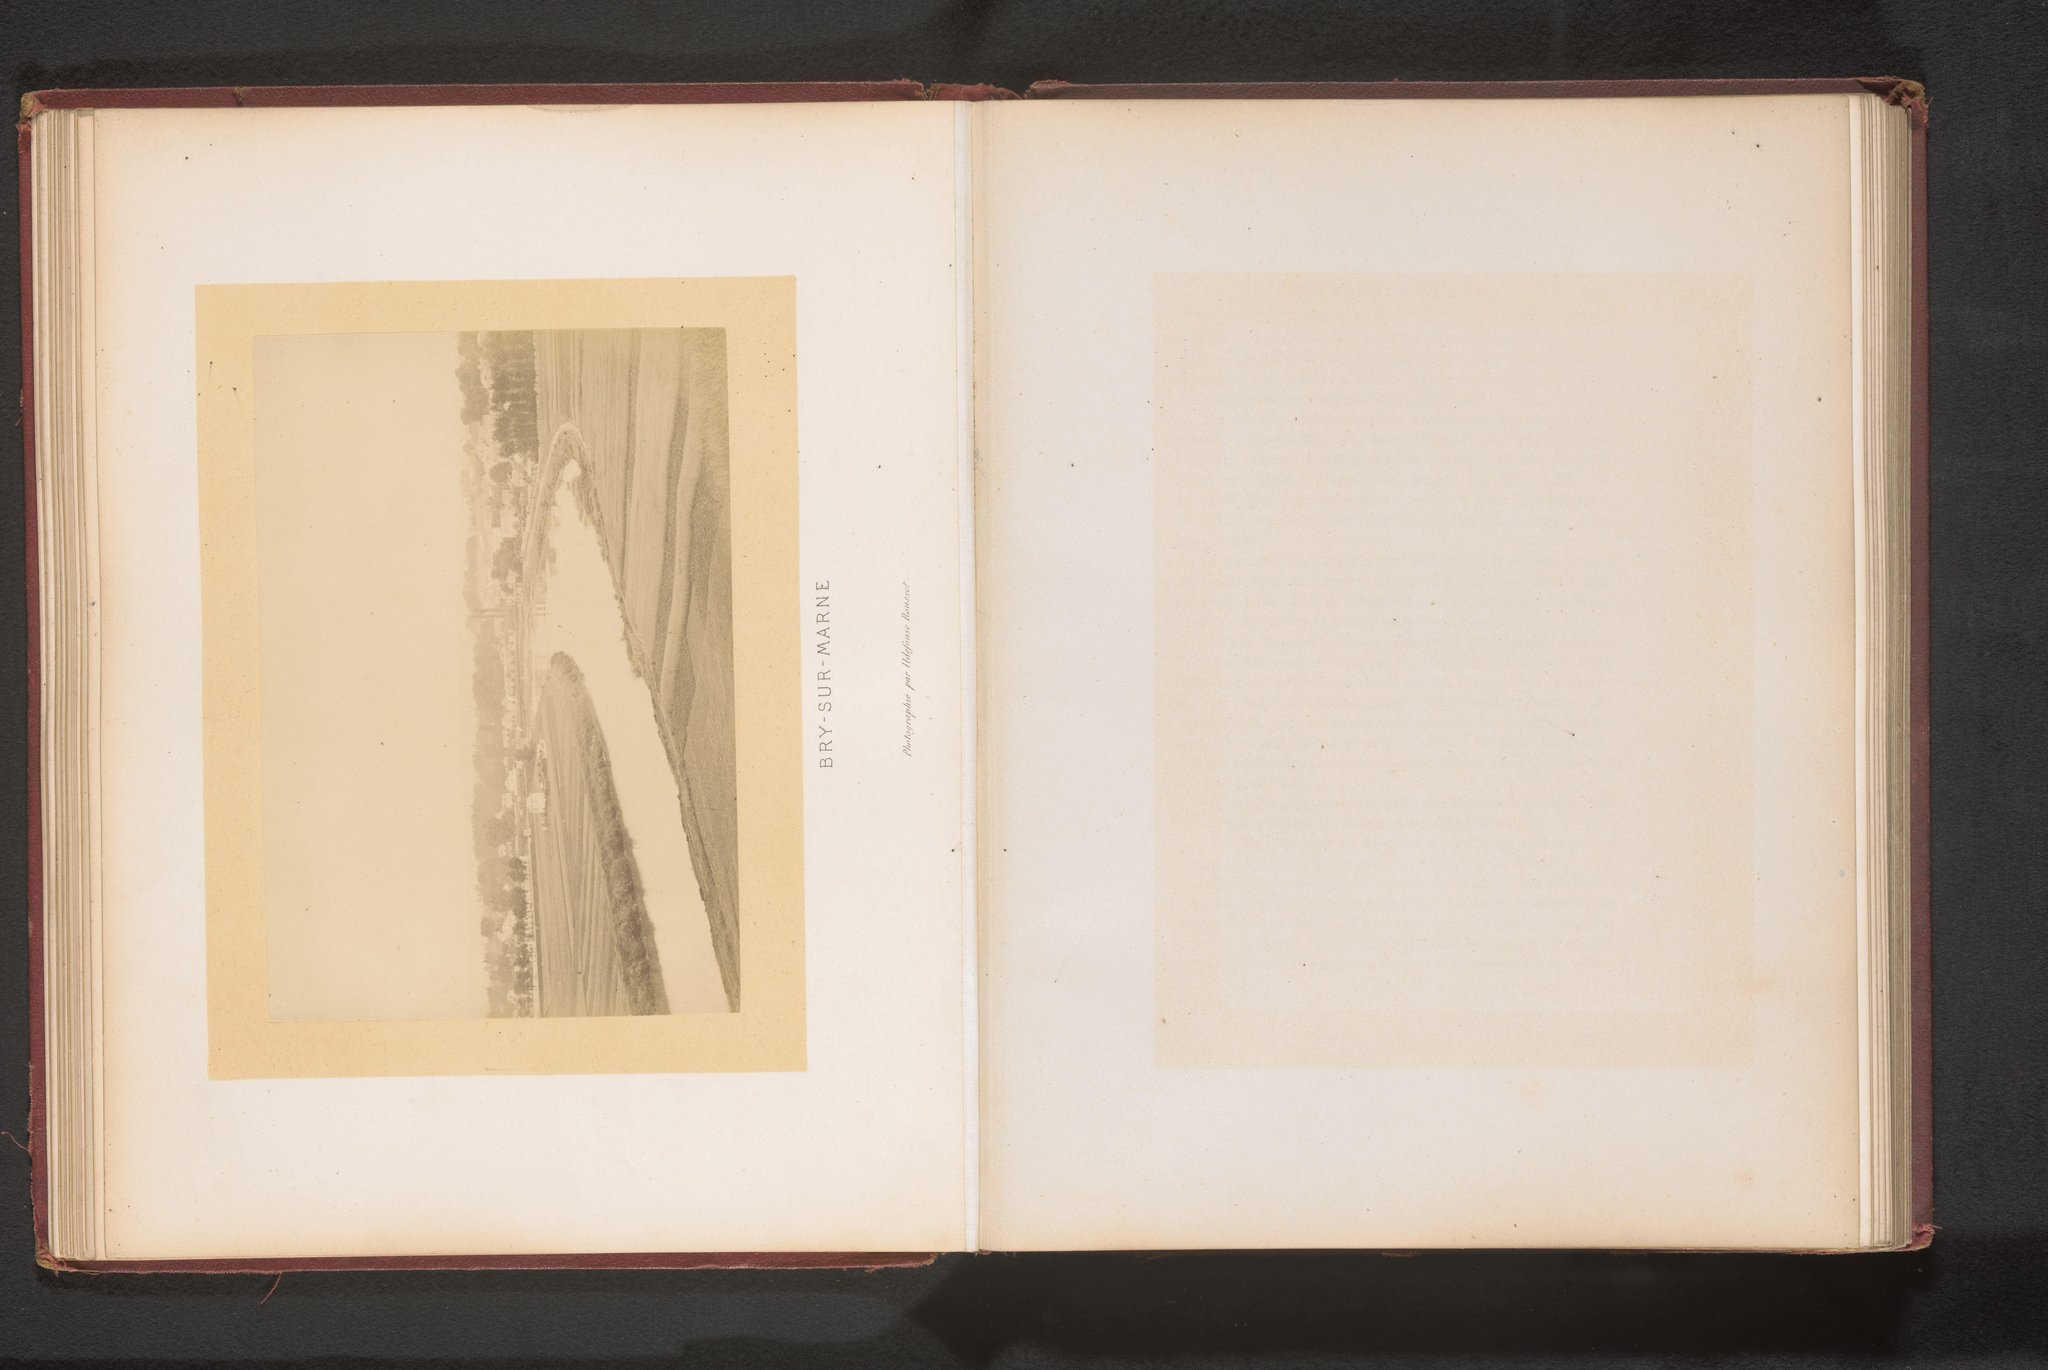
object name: photograph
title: Bry-sur-Marne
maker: ildefonse rousset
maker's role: fotograaf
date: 1860-1865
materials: photographic support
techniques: albumen print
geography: ile-de-france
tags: city-view in general; 'veduta', river